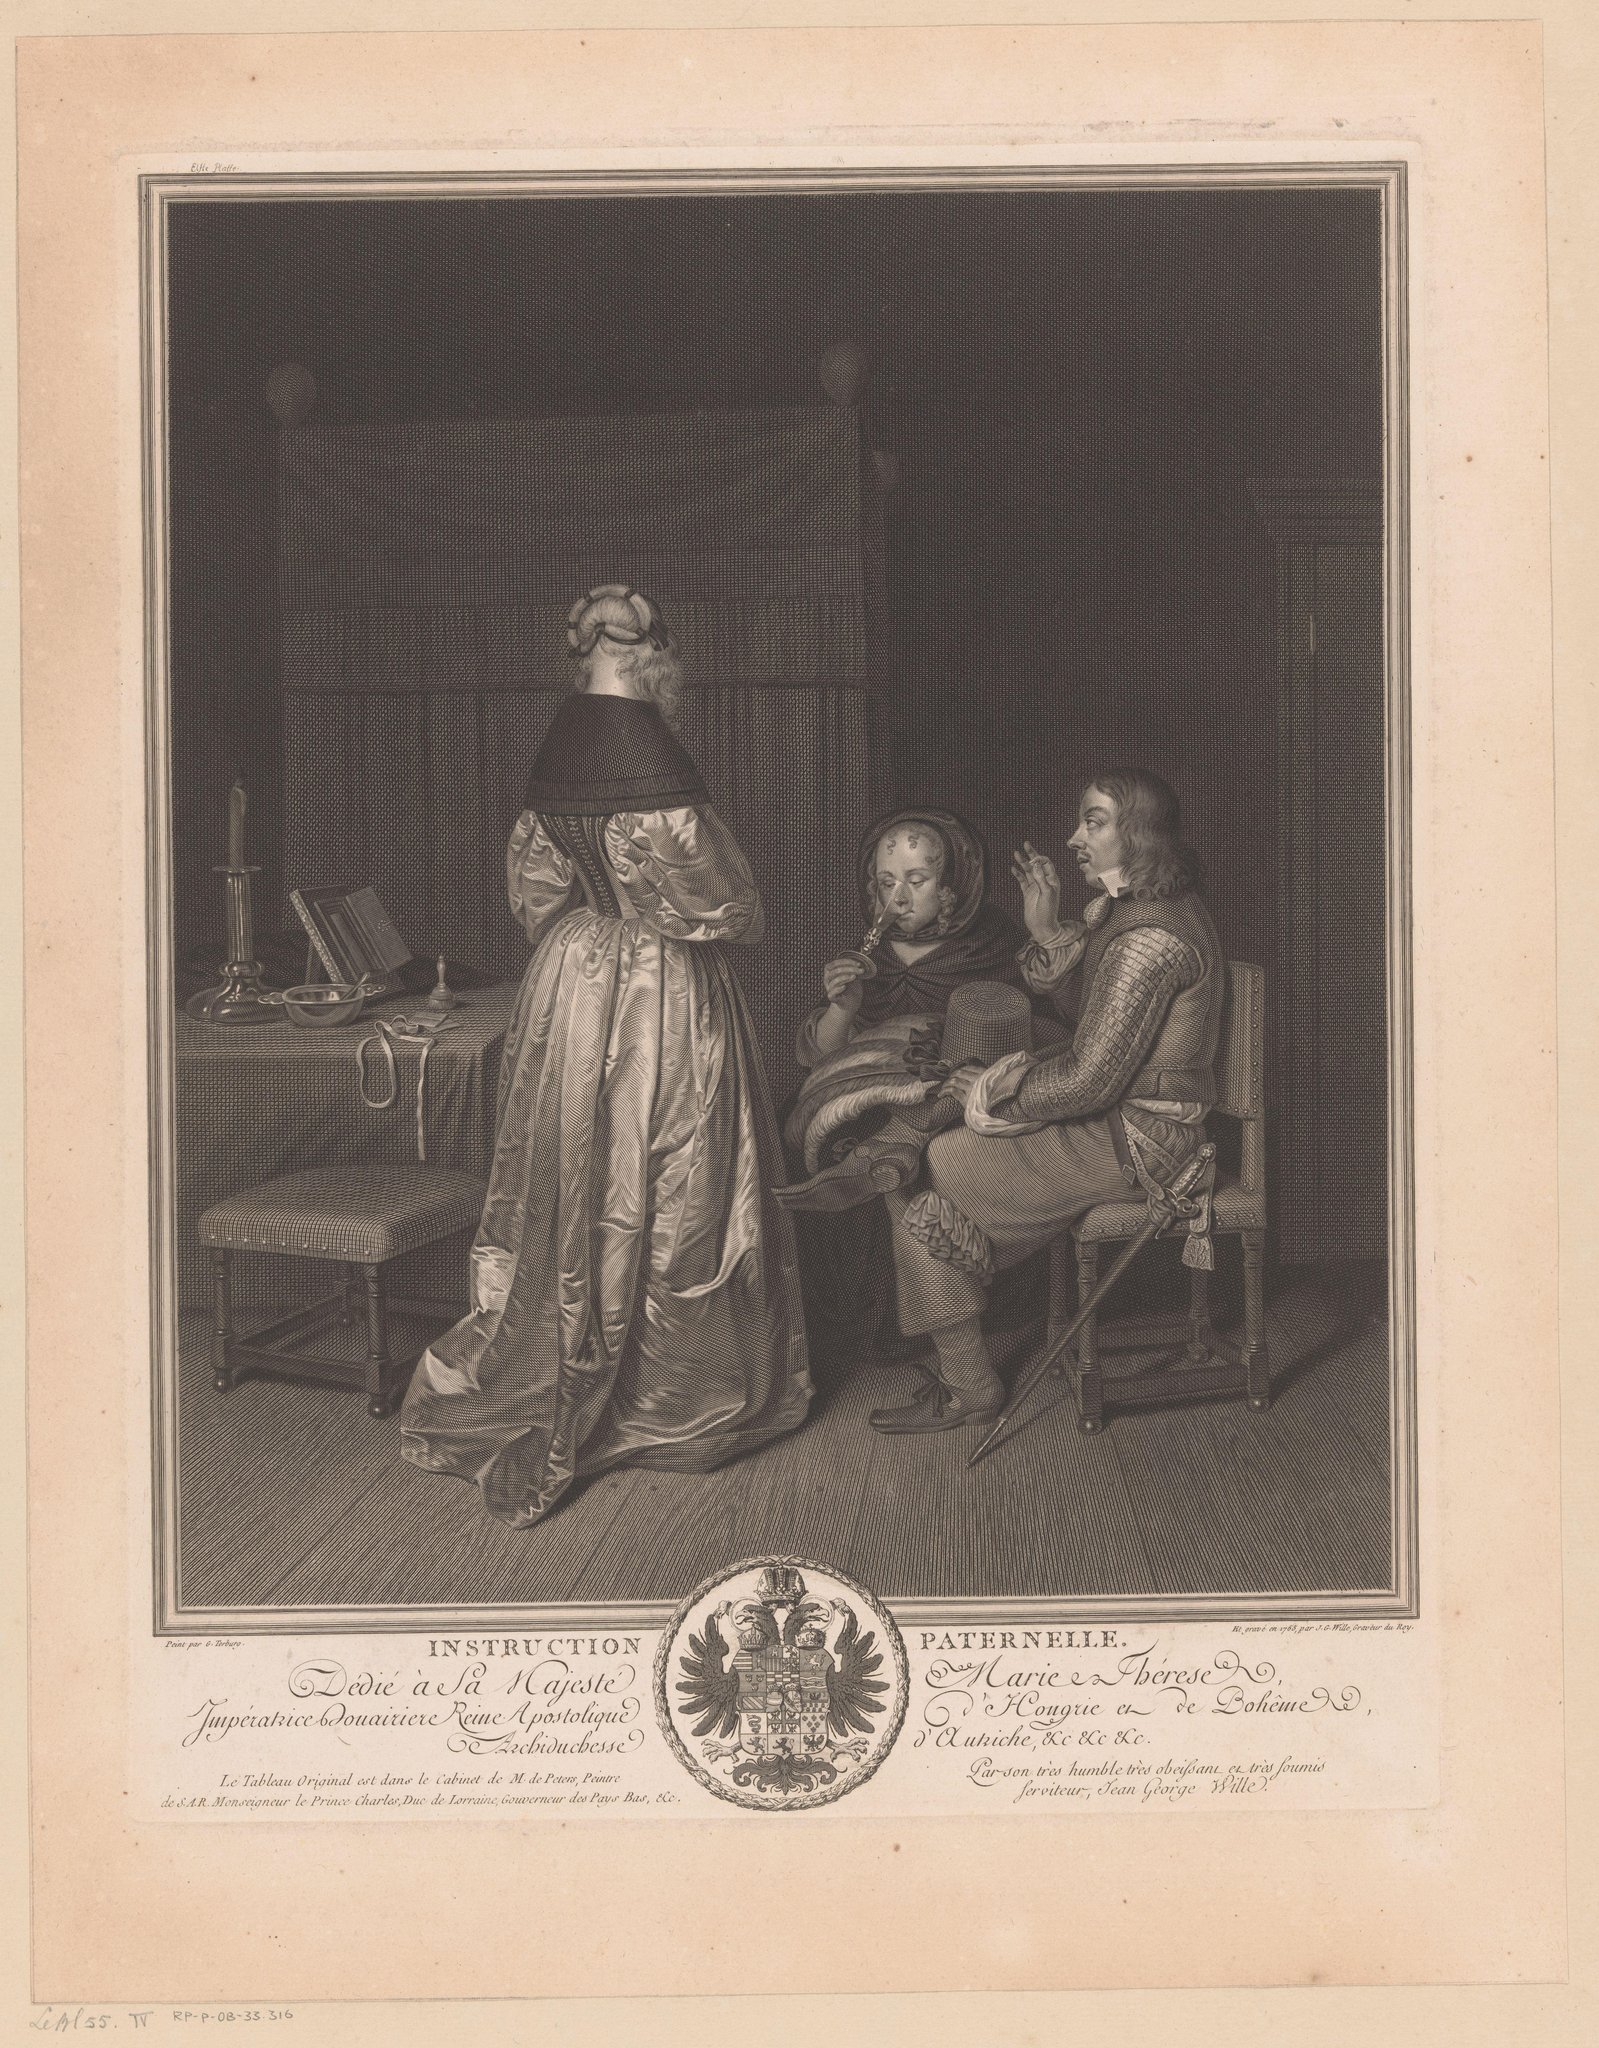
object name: print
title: Instruction paternelle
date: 1765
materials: paper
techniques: engraving, etching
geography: paris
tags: candle, interior of the house, drinking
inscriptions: collector's mark: Lugt 240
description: Deze prent maakt deel uit van een serie van onbekende omvang naar Nederlandse en Duitse schilderijen. Op sommige prenten staat linksboven aangegeven welk nummer in de serie het betreft.